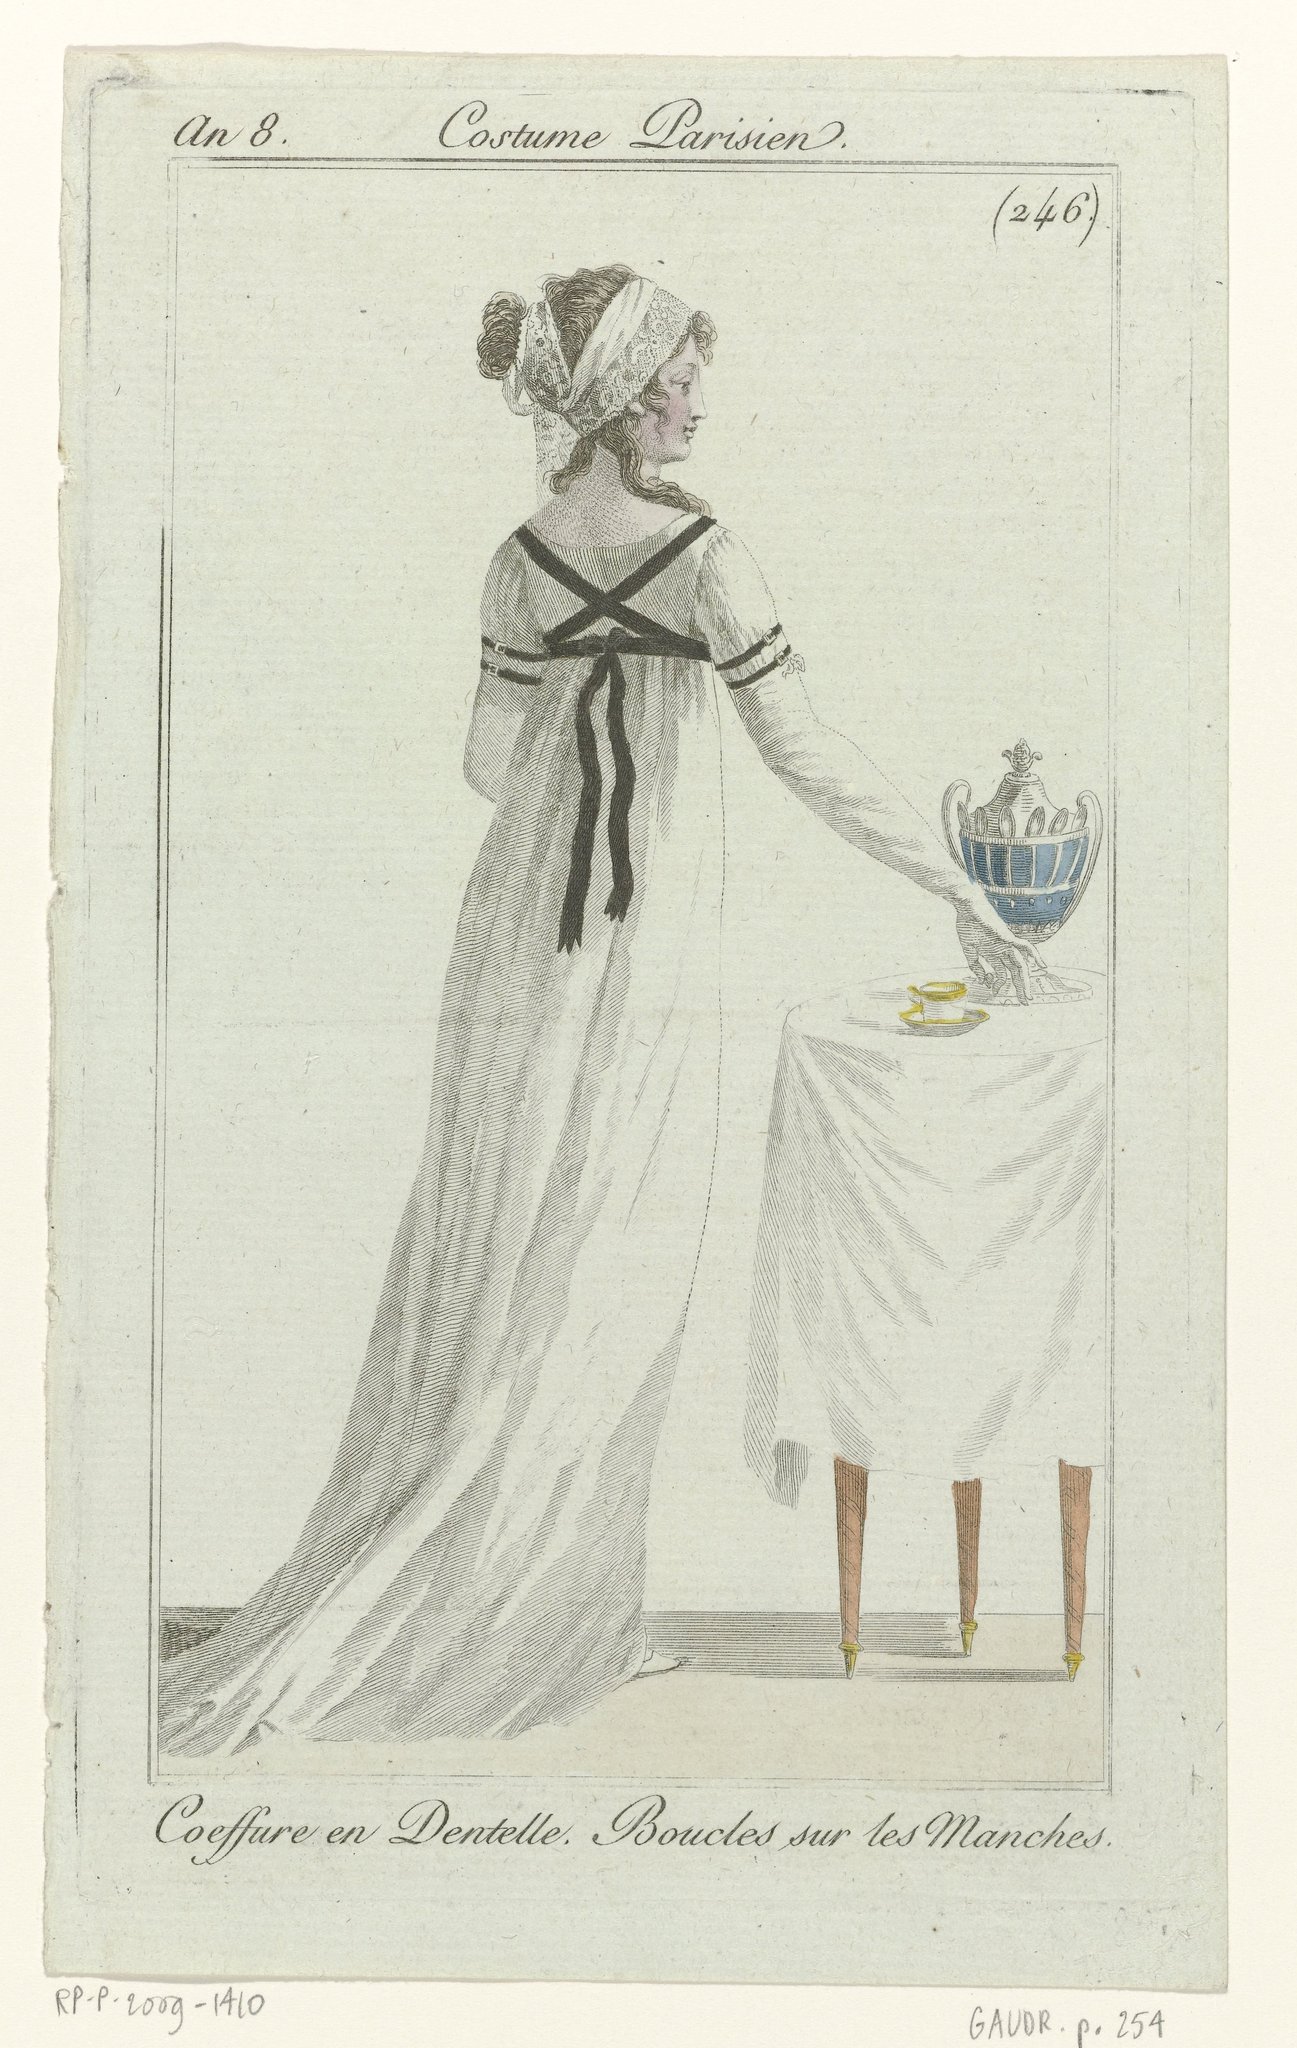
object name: fashion print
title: Journal des Dames et des Modes, Costume Parisien, 22 sept. 1800, An 8 (246) : Coeffure en dentell (...)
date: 1800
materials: paper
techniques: engraving, hand coloring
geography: paris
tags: gloves, mittens (long gloves) (+ women's clothes), ornamental parts of clothing (+ women's clothes), head-gear (+ women's clothes), styles of hairdress - aa - ~ women, fashion plates, shoes, sandals (+ women's clothes), dress, gown (+ women's clothes), lace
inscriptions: title: ‘Costume Parisien.’, caption: ‘Coeffure en dentelle. Boucles sur les Manches.’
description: 'Coiffure en Dentelle'. Japon met korte mouwen, versierd met contrasterend banden met gespen. Op de rug een gekruist en gestrikt lint. Sleep. Lange handschoenen. De prent maakt deel uit van het modetijdschrift Journal des Dames et des Modes, uitgegeven door Pierre de la Mésangère, Parijs, 1797-1839.